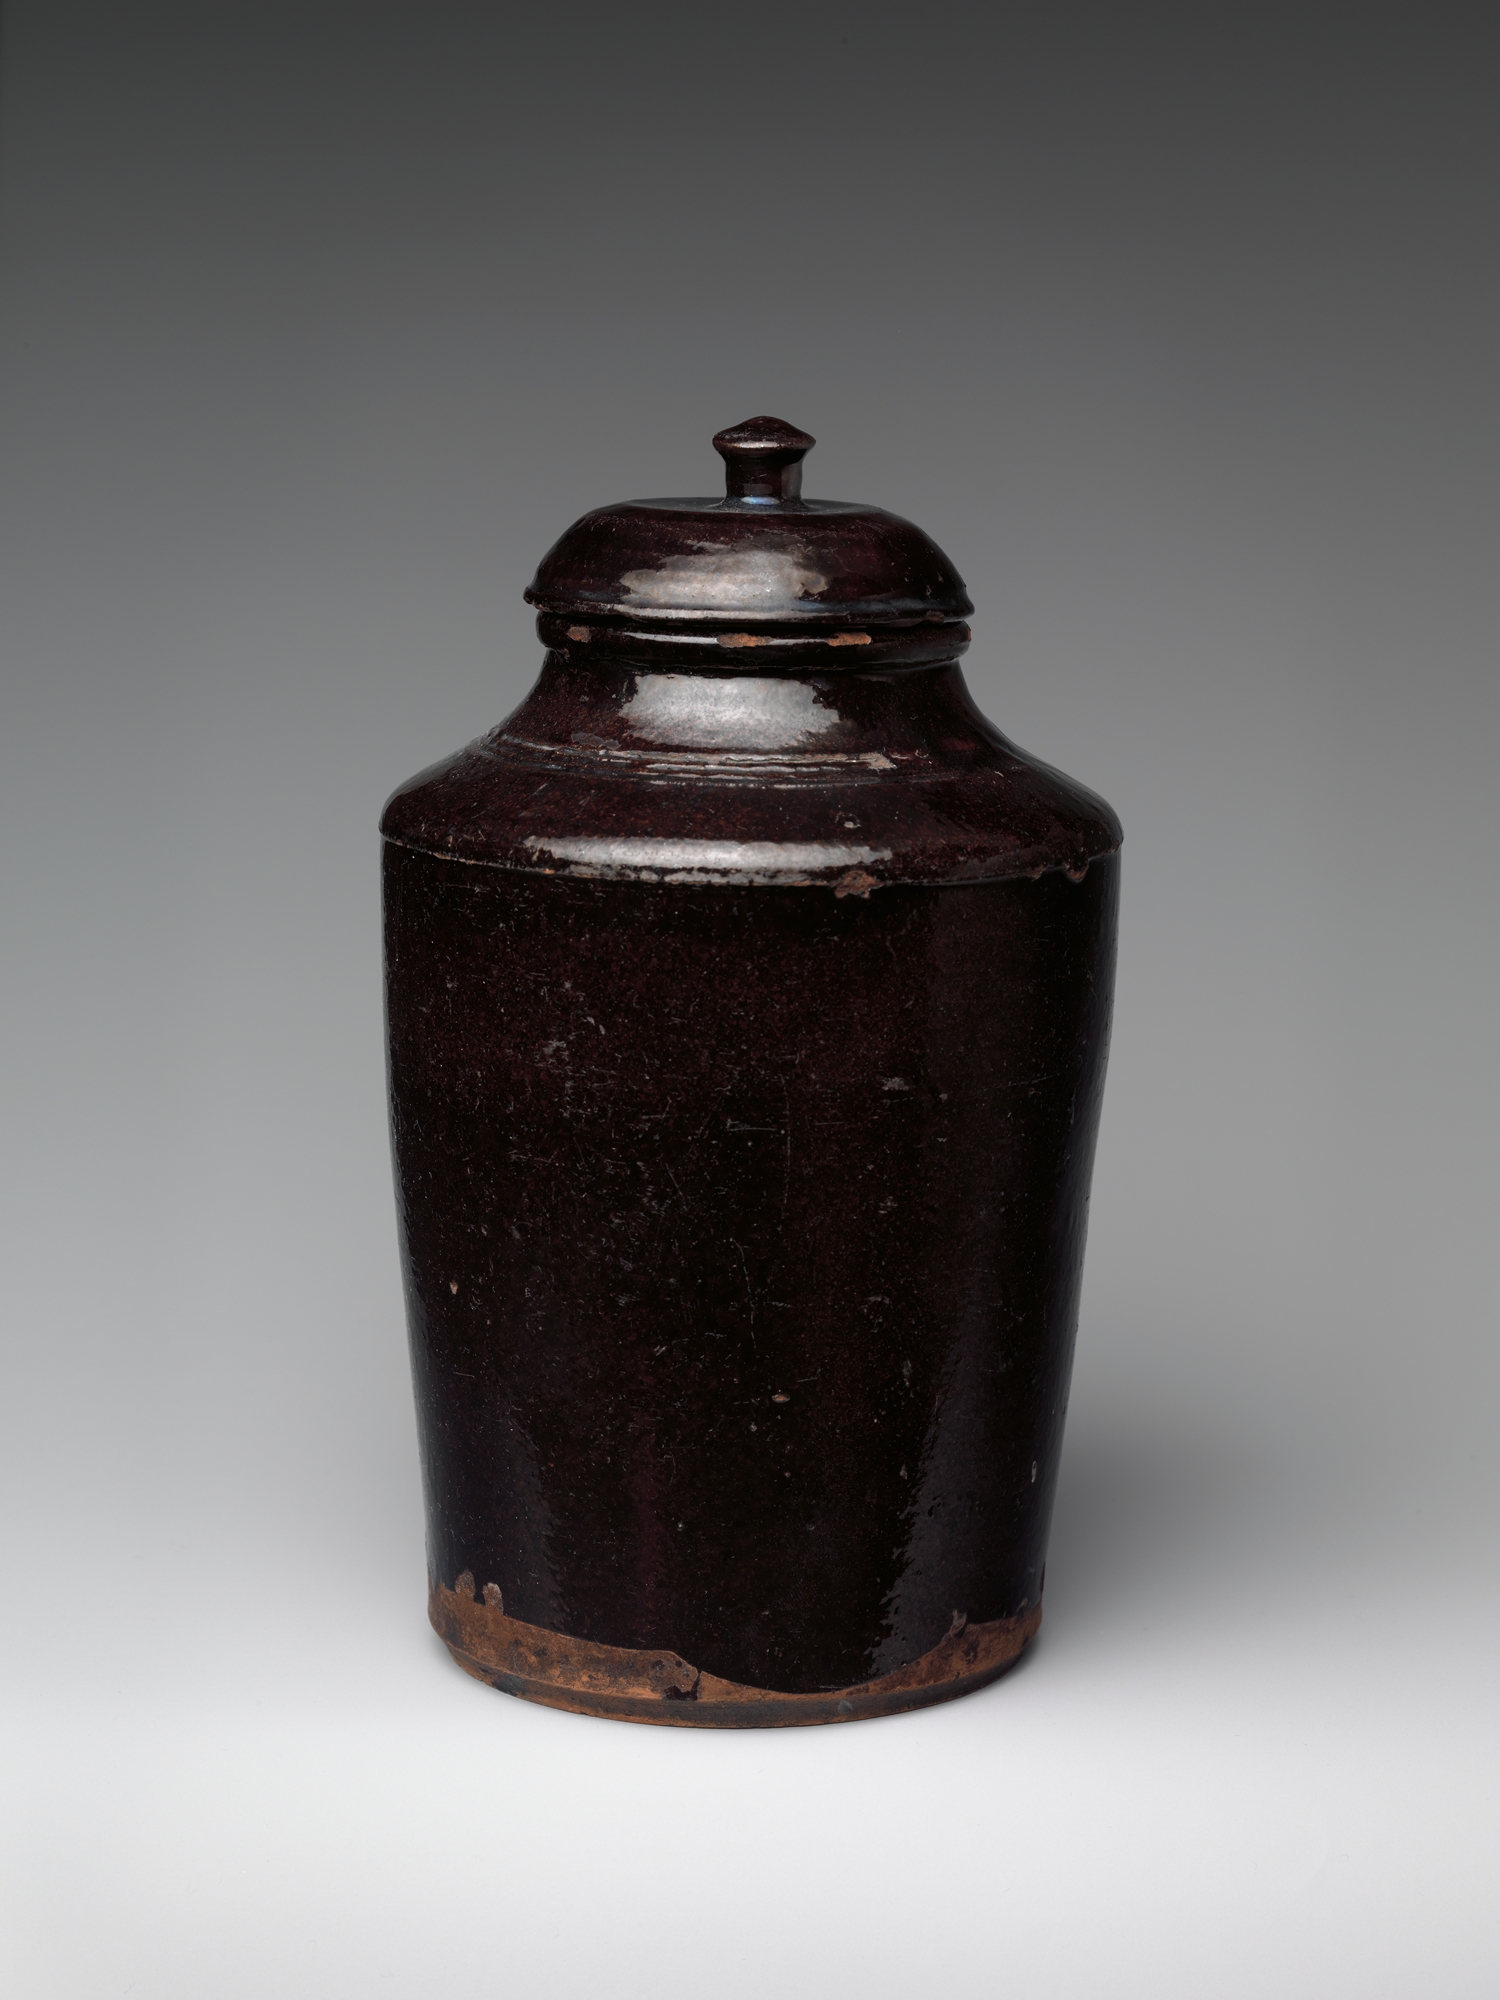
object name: jar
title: Covered Jar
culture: american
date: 1800-1900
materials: stoneware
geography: united states